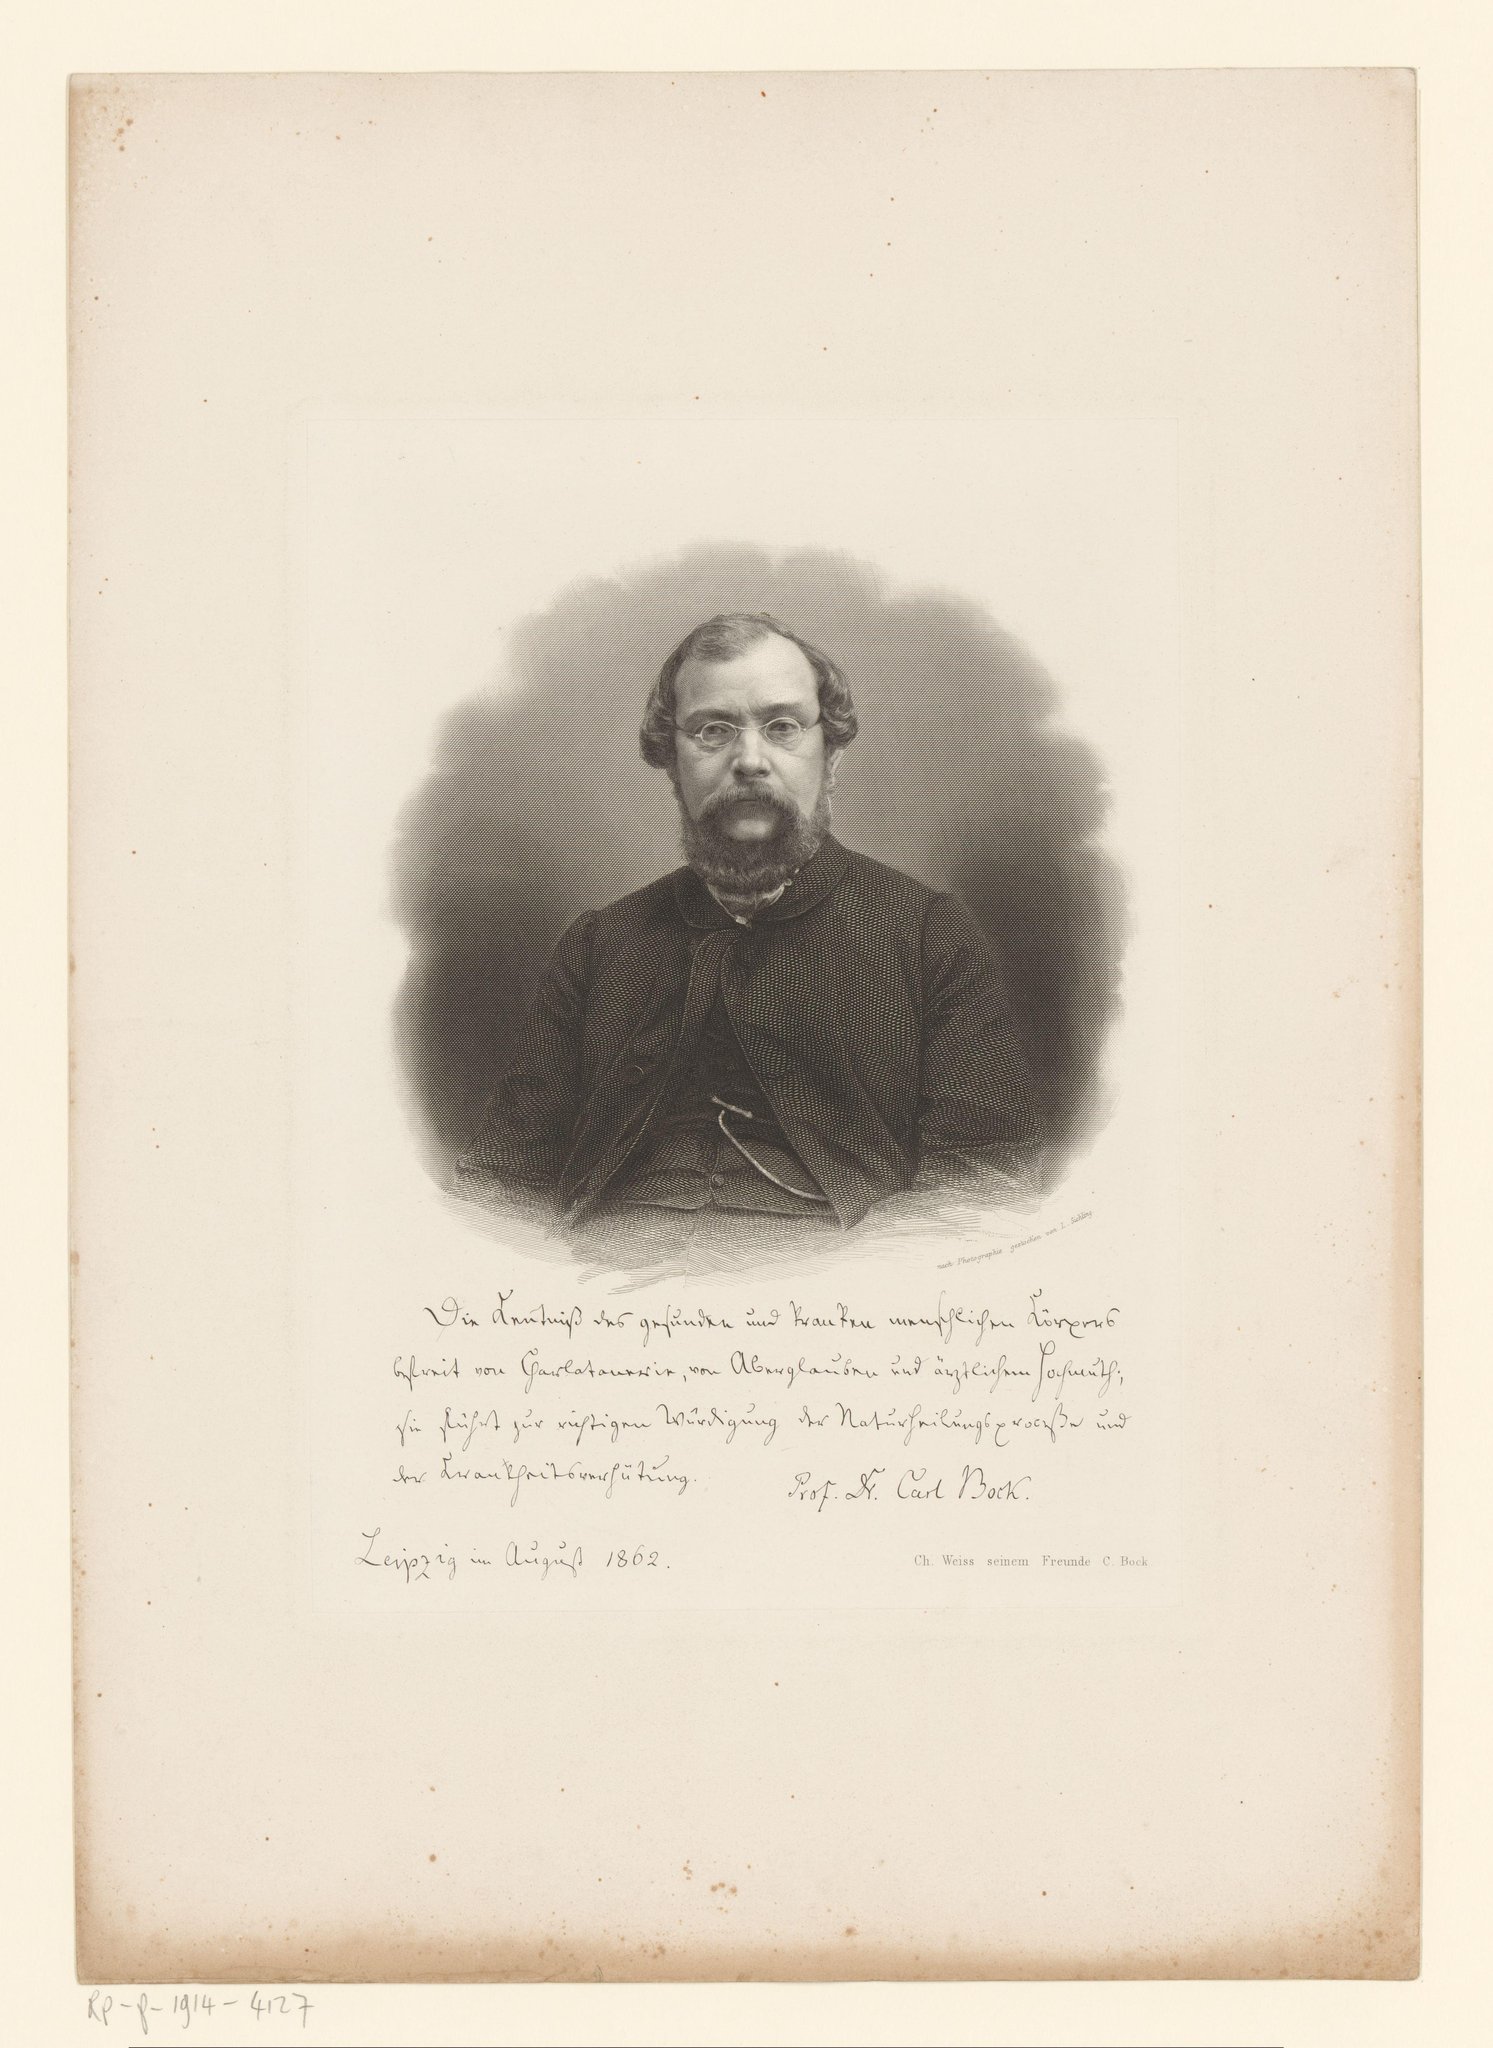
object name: print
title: Portret van Carl Ernst Bock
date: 1822-1863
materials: paper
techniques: engraving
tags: historical persons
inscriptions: collector's mark: Lugt 2228